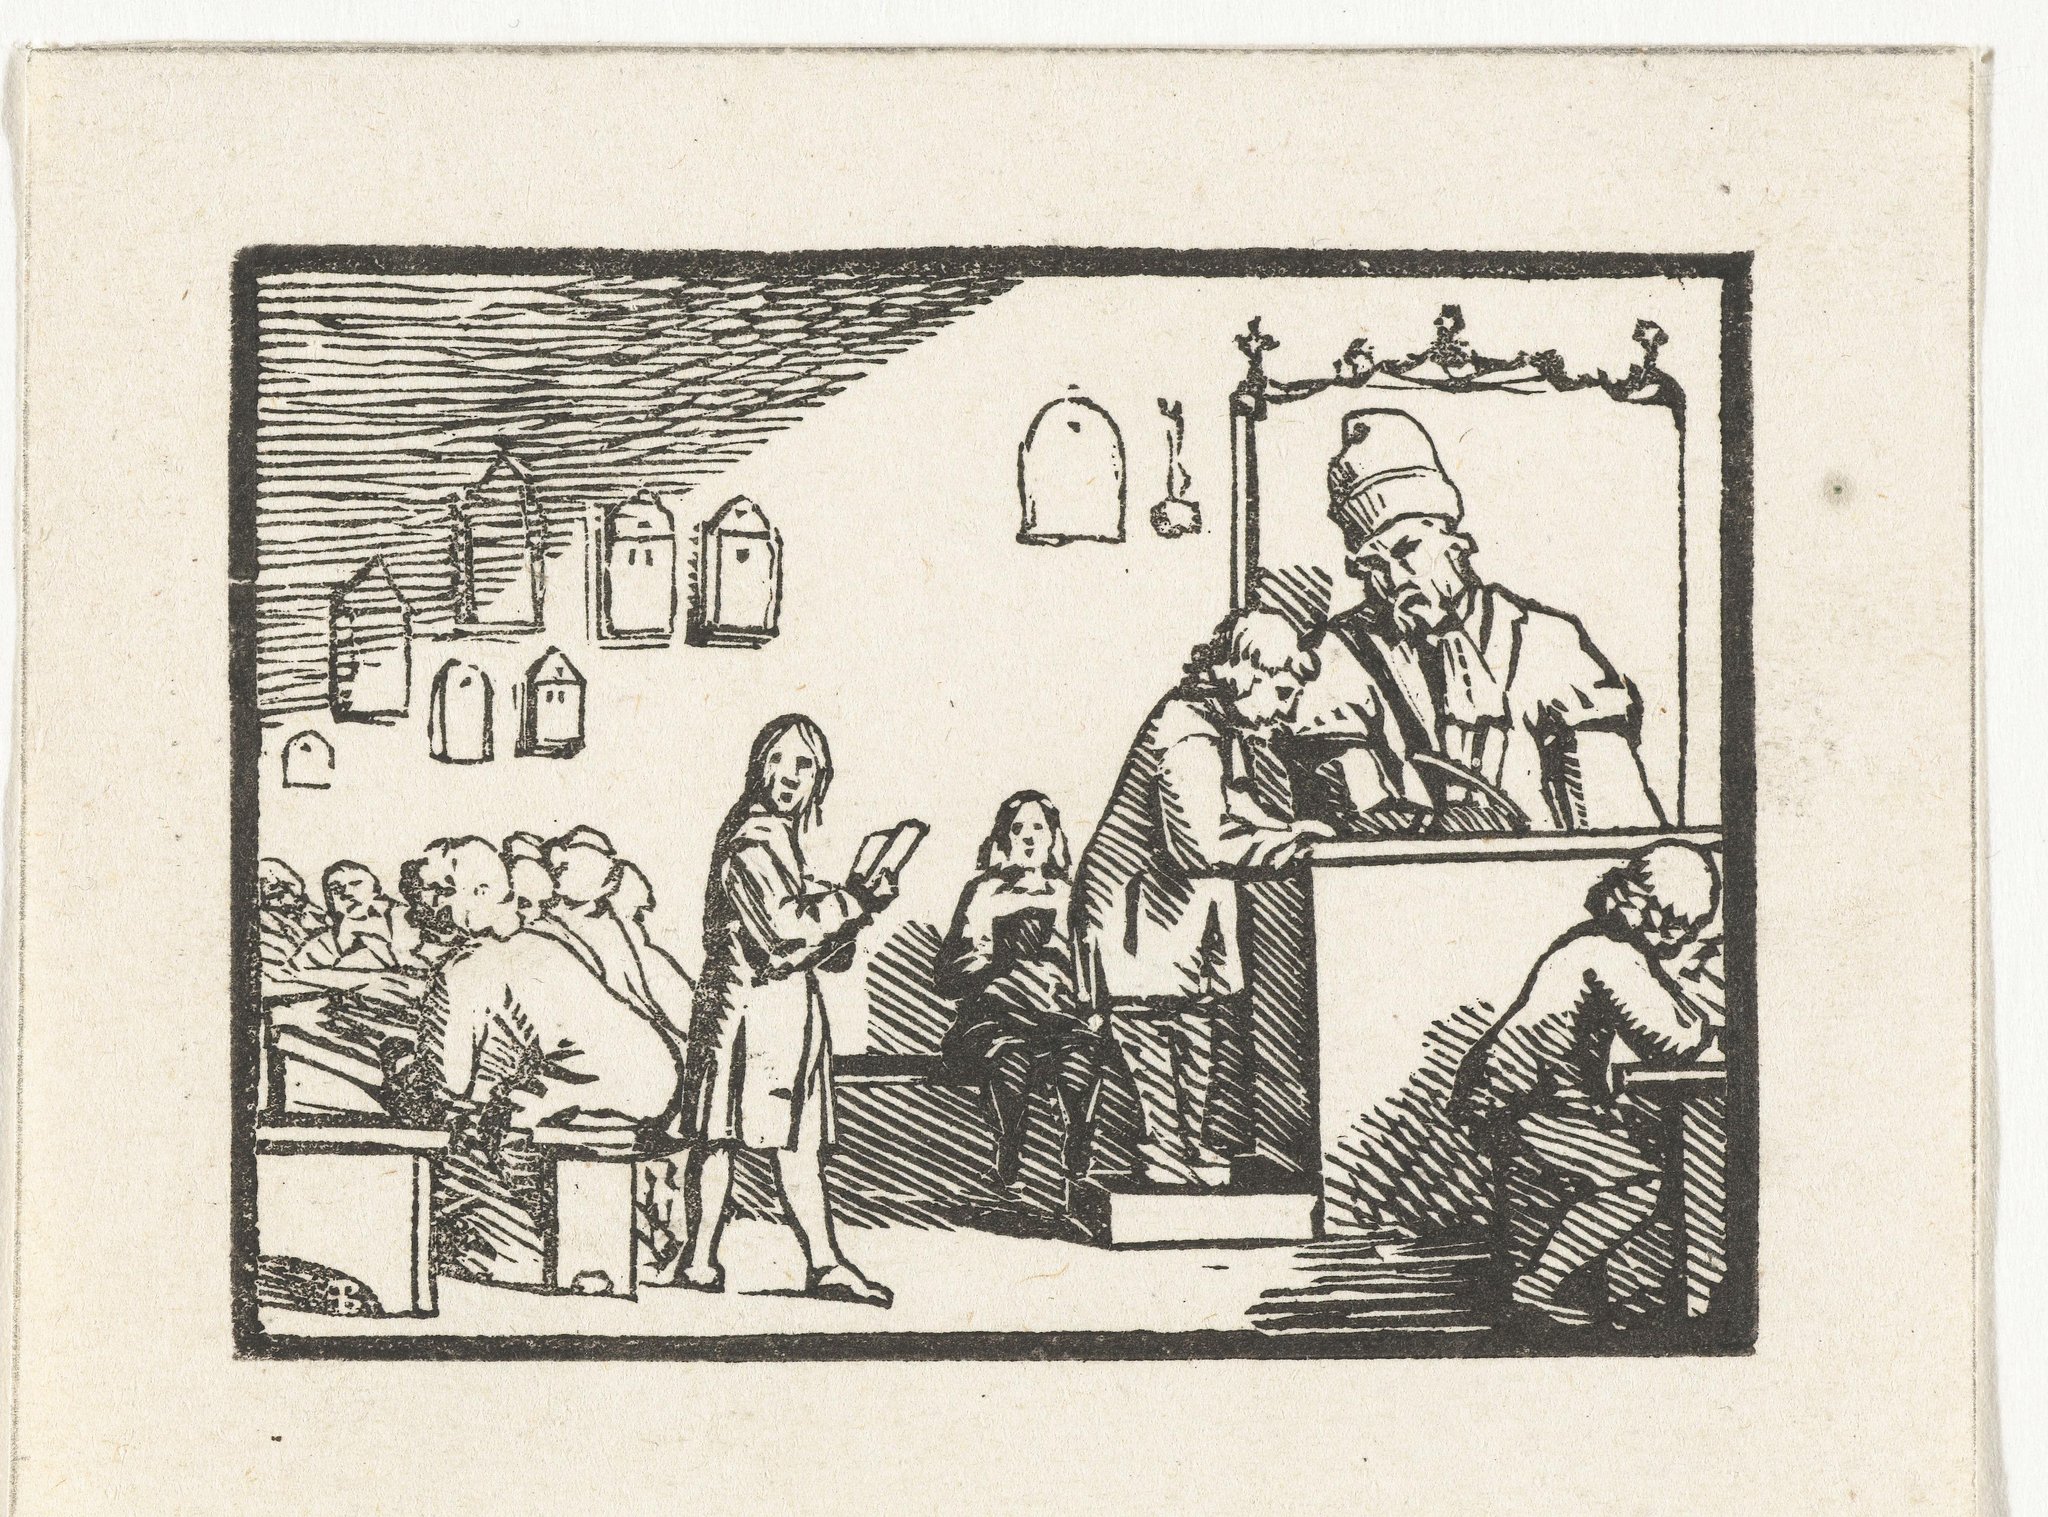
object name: print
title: Schoolmeester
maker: dirck de bray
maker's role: draughtsman, painter, print maker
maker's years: 1625-1694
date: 1650-1694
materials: paper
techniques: woodcut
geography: netherlands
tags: teacher and pupil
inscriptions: collector's mark: Lugt 2228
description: Een schoolmeester zit achter zijn tafel in een klaslokaal. Om hem heen zijn leerlingen aan het werk.